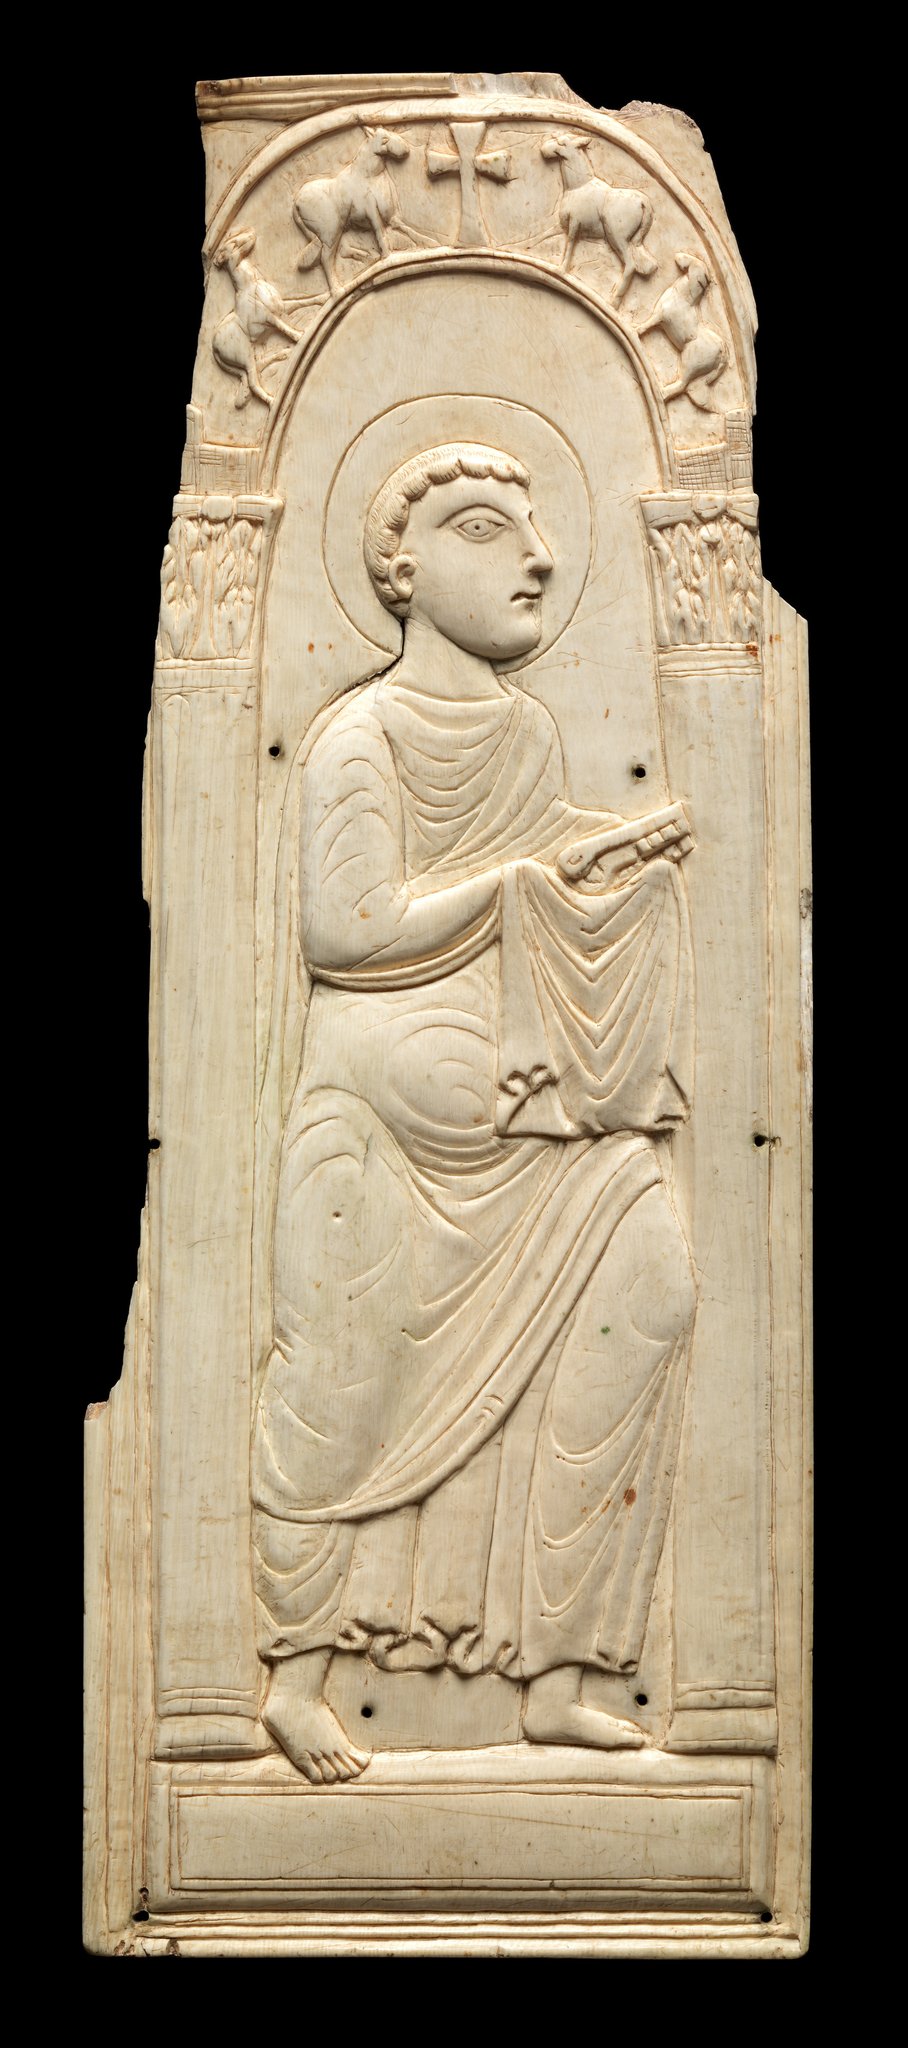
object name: plaque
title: Ivory Panel with Saint Peter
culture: frankish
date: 501-800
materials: ivory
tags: saint peter